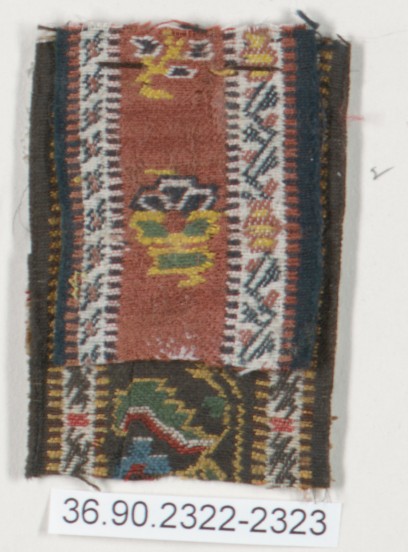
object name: border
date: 1801-1900